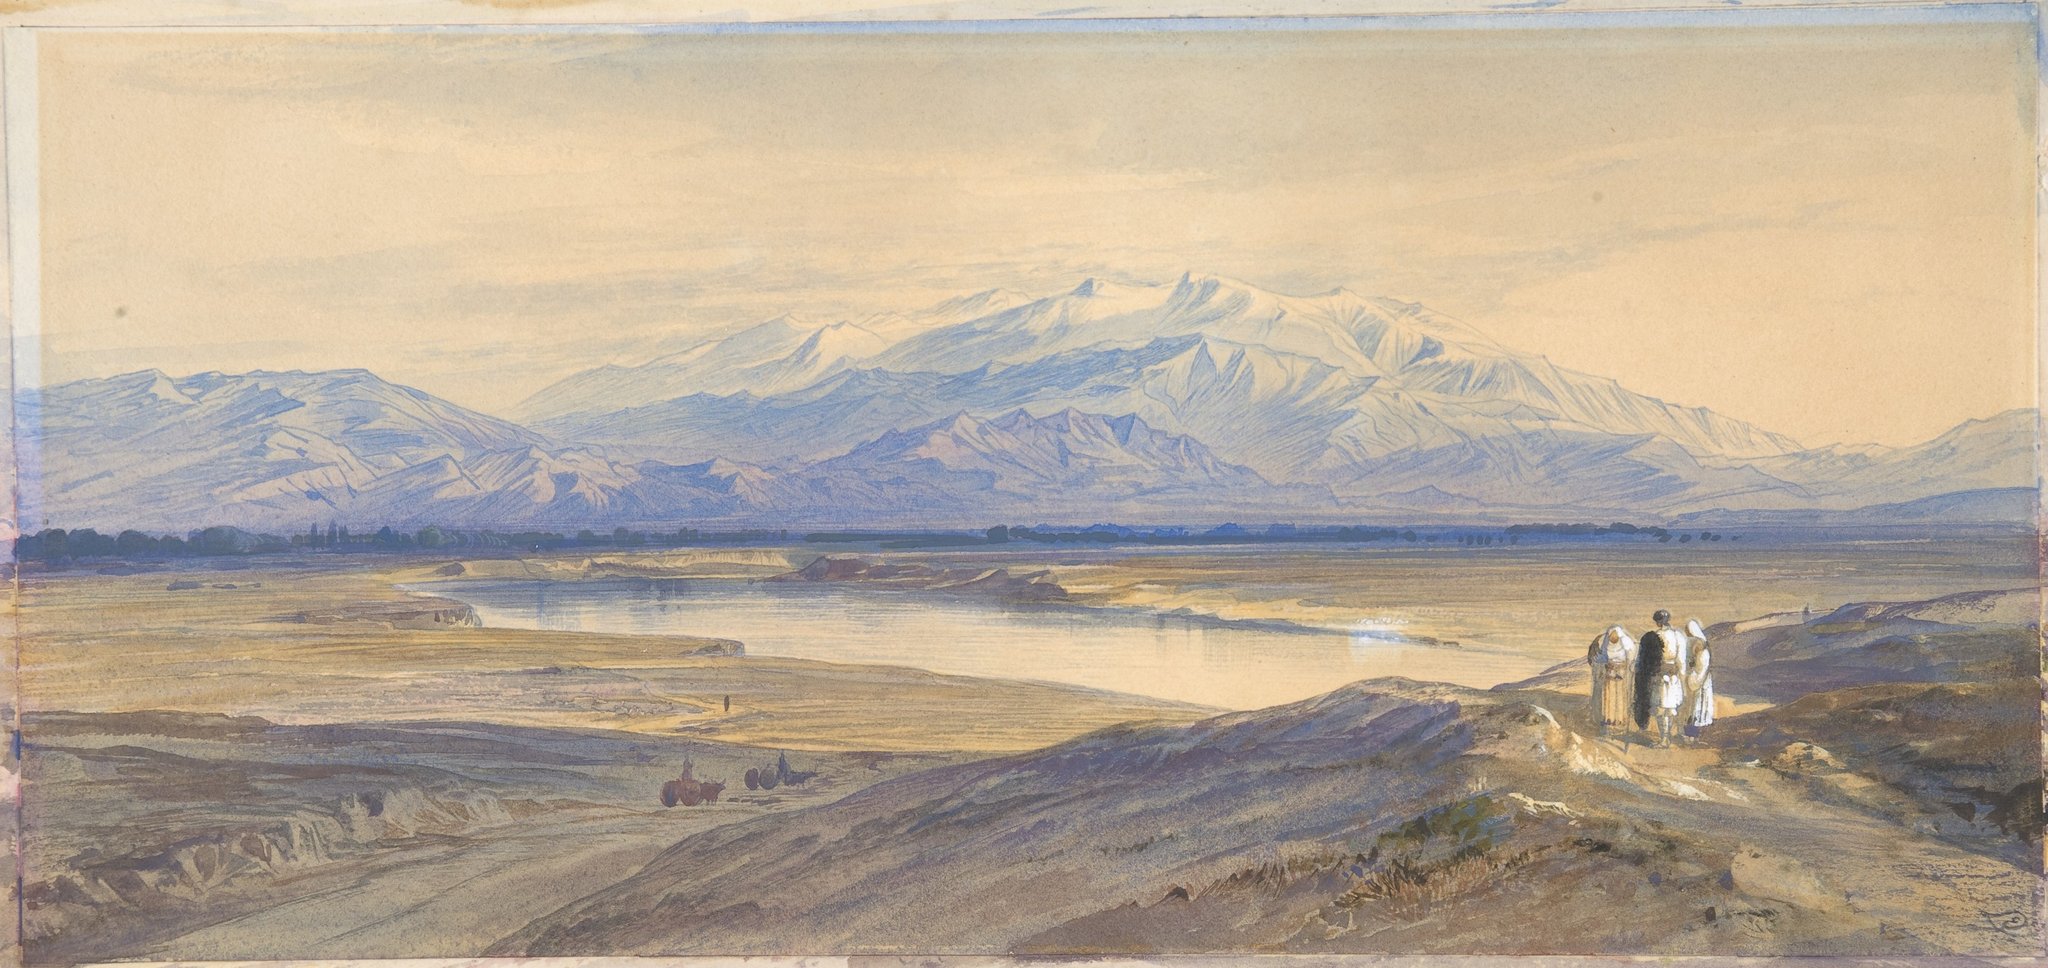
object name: drawing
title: Mount Olympus from Larissa, Thessaly, Greece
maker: edward lear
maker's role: artist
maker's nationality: british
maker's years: 1812-1888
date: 1850-1885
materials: watercolor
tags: men,women,lakes,mountains,landscapes